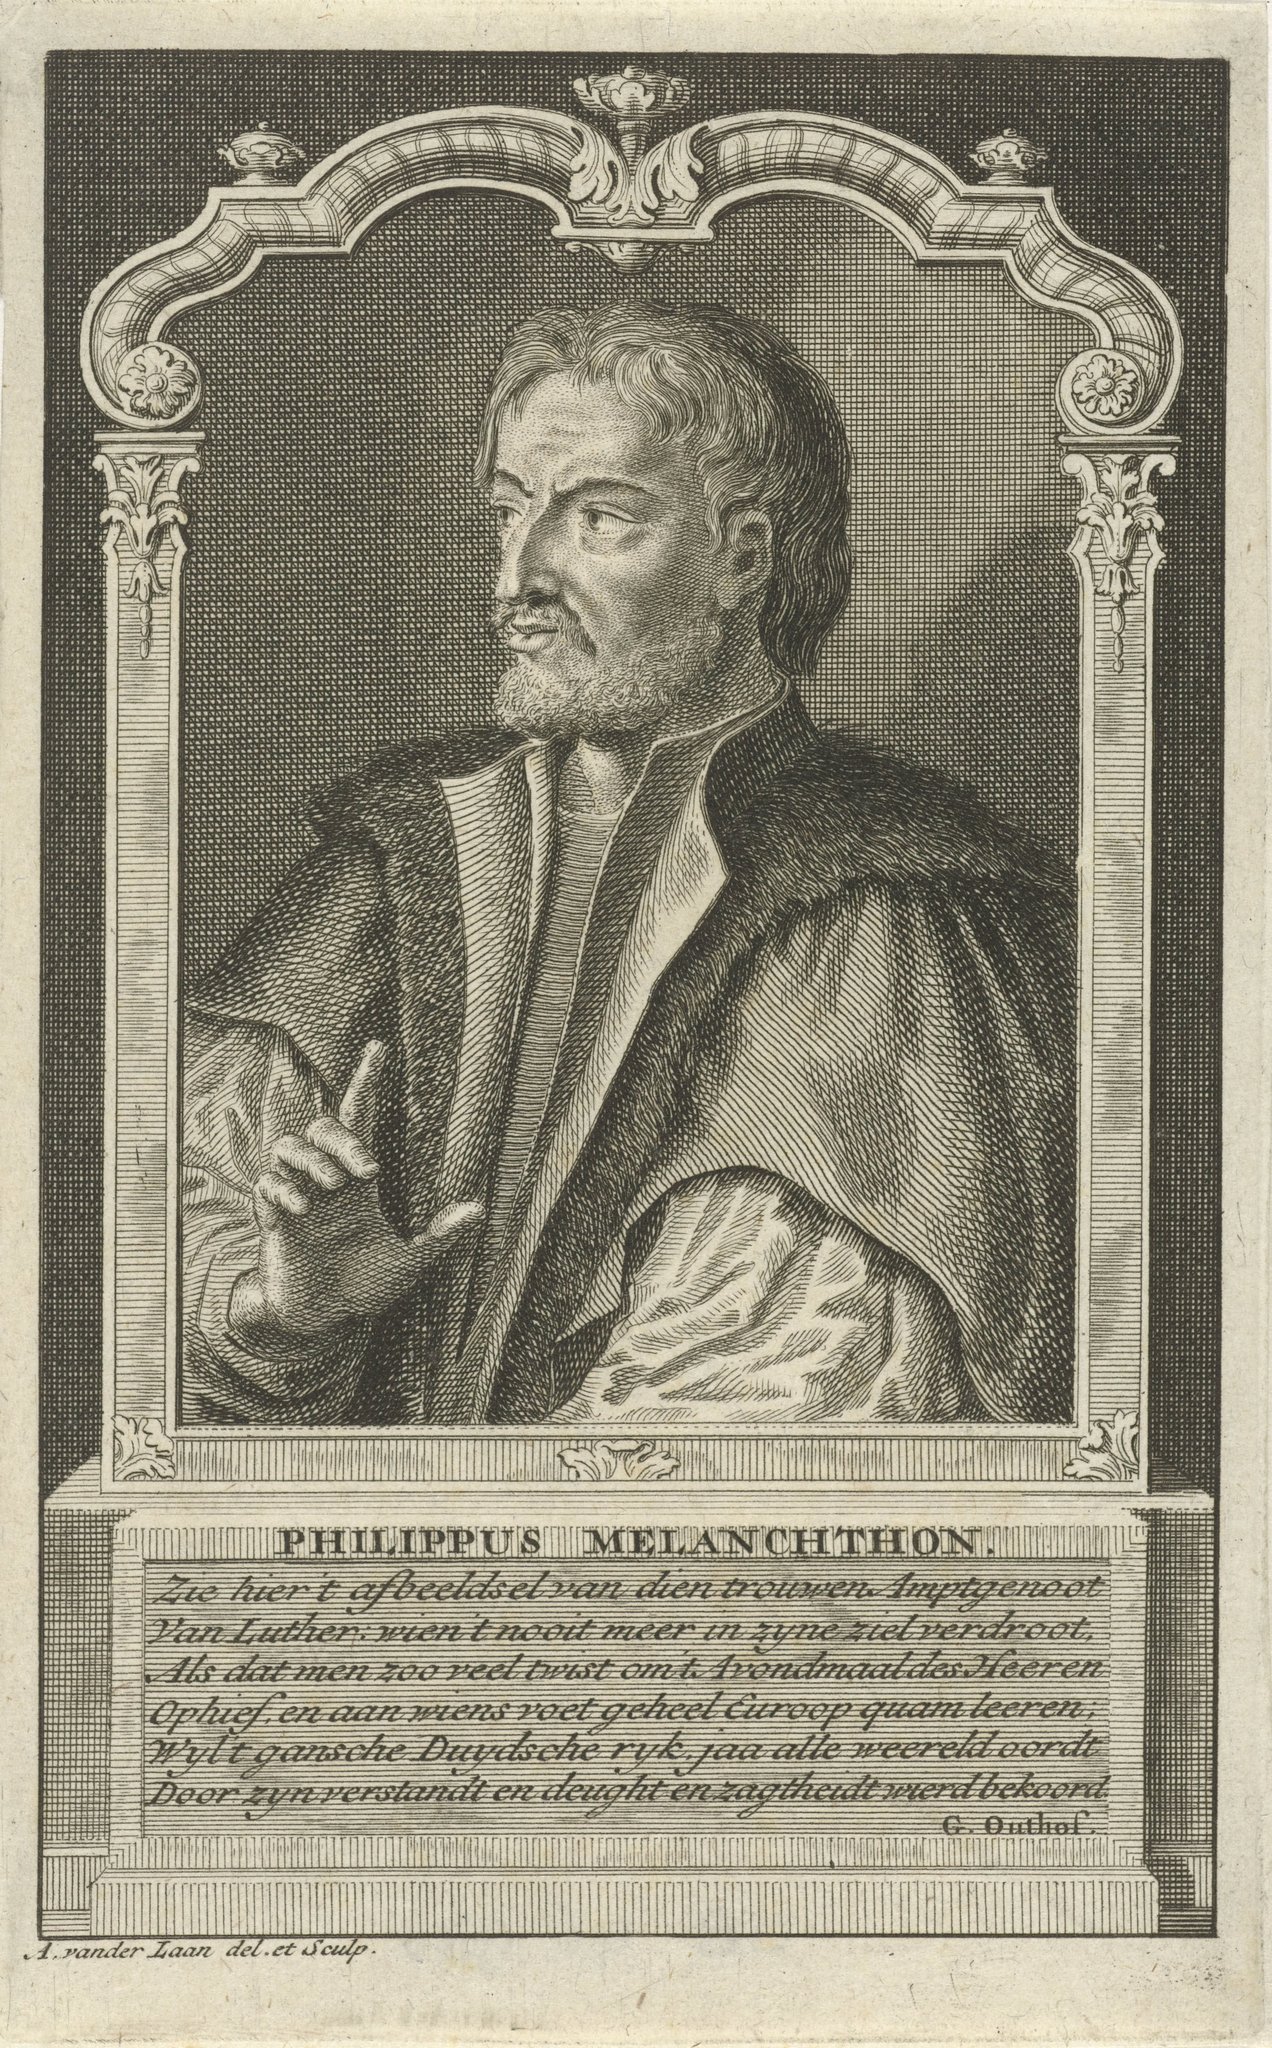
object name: print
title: Portret van Philipp Melanchton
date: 1694-1755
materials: paper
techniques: engraving, etching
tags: bretten, filosoof, luthers theoloog, philipp melanchthon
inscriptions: collector's mark: Lugt 2228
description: Portretbuste naar links van de Duitse kerkhervormer Philipp Melanchton, blootshoofds. Rondom een ornamentele omlijsting, op de sokkel onder het portret de naam van de geportretteerde en een zesregelig Nederlands vers.